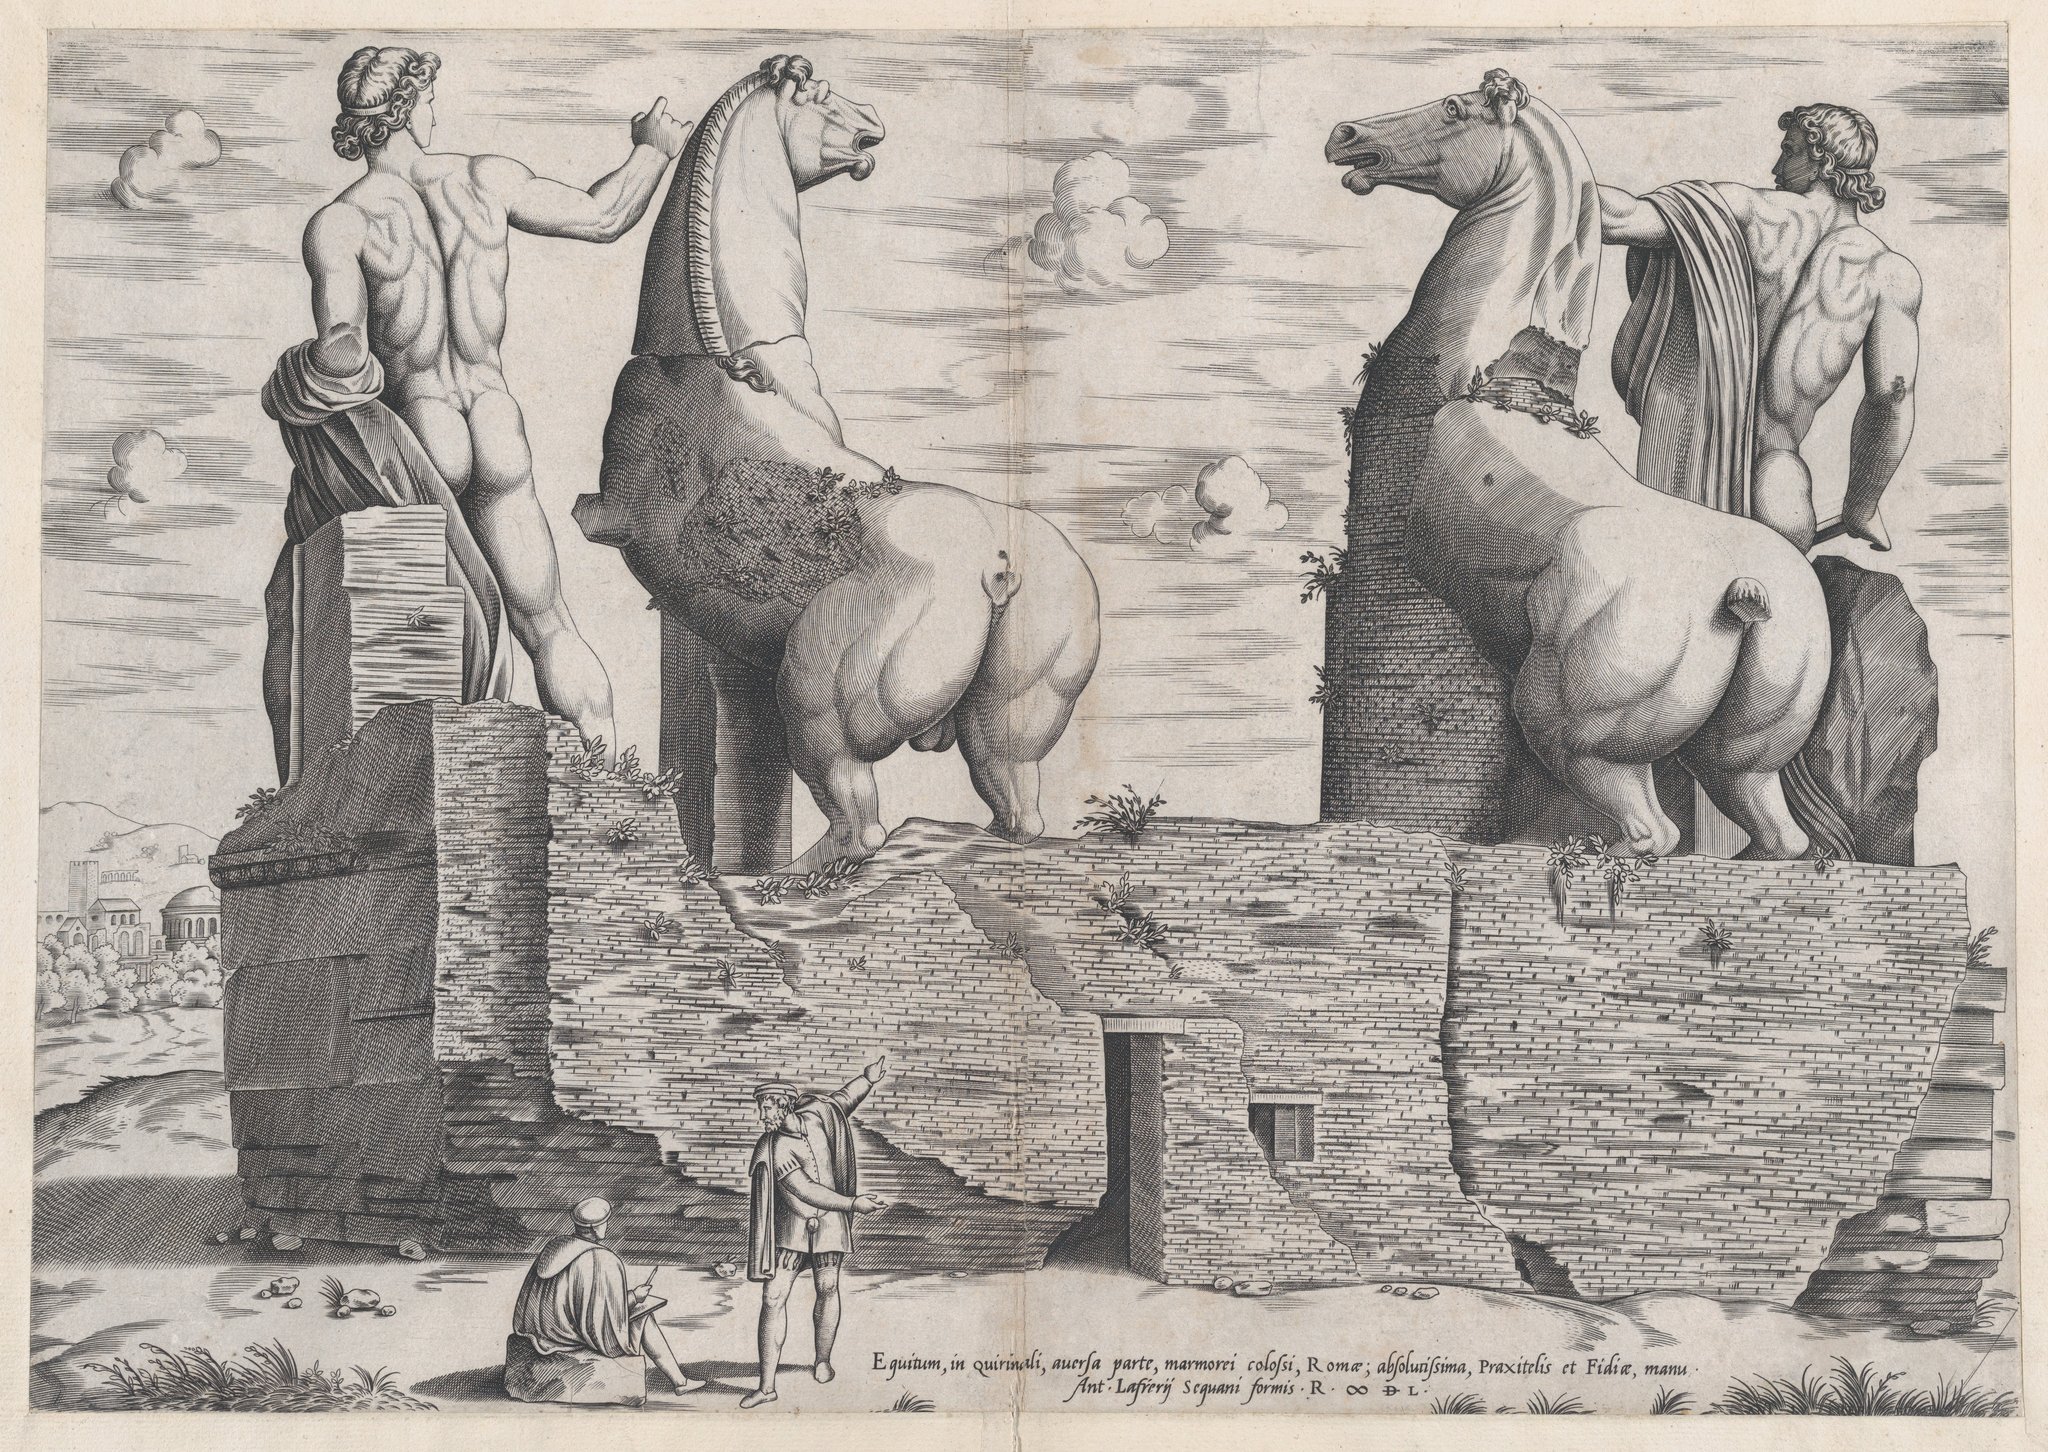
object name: print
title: View of the Back of the Statues of the Dioscuri at the Quirinal, from "Speculum Romanae Magnificentiae"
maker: Anonymous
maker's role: artist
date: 1550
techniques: engraving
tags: sculpture,ruins,men,horses